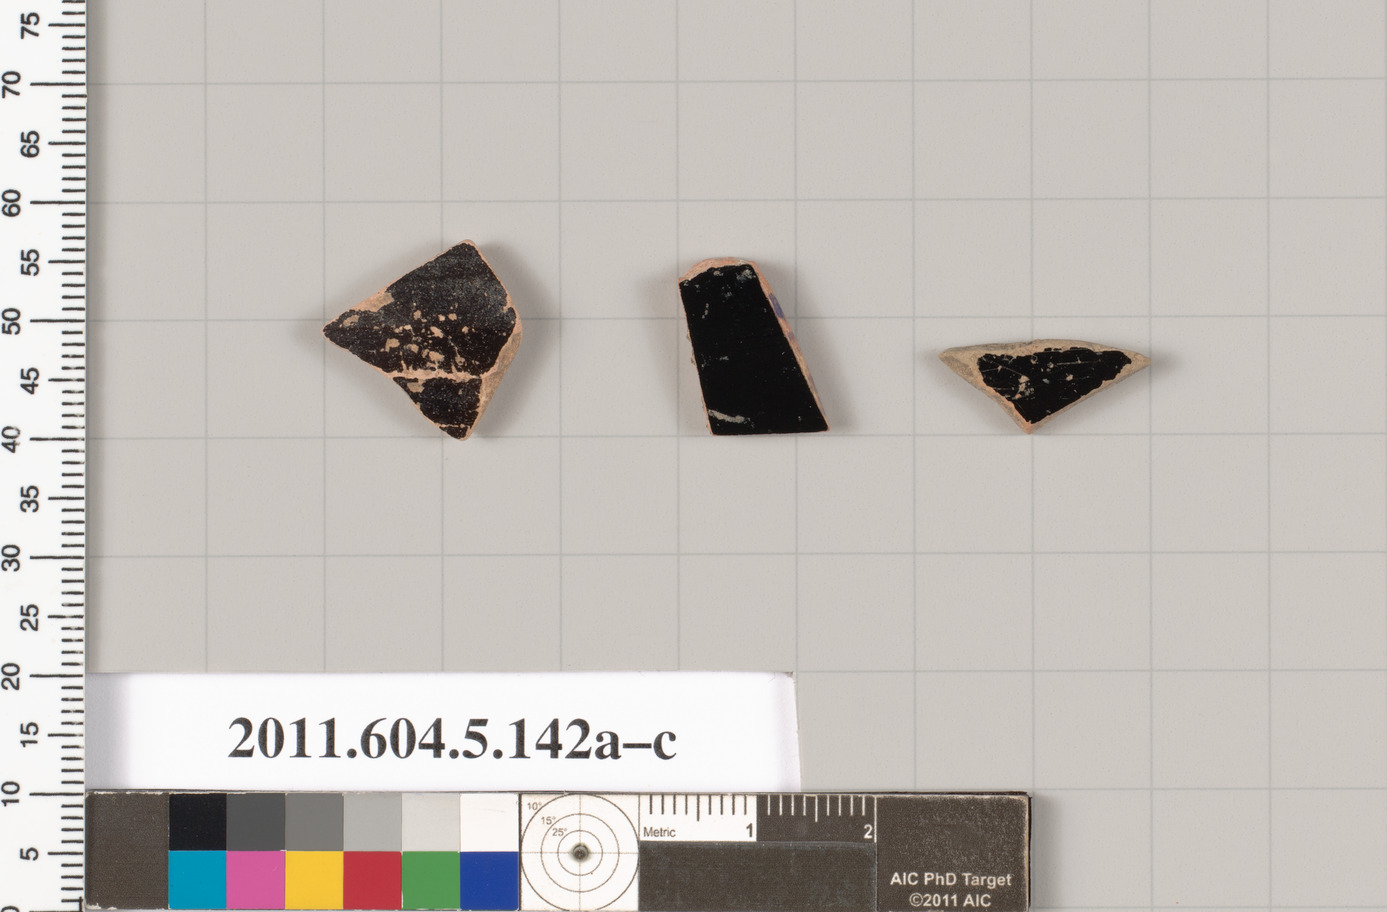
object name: kylix fragment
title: Terracotta fragments of kylikes (drinking cups)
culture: greek, attic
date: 600-401 BCE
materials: terracotta